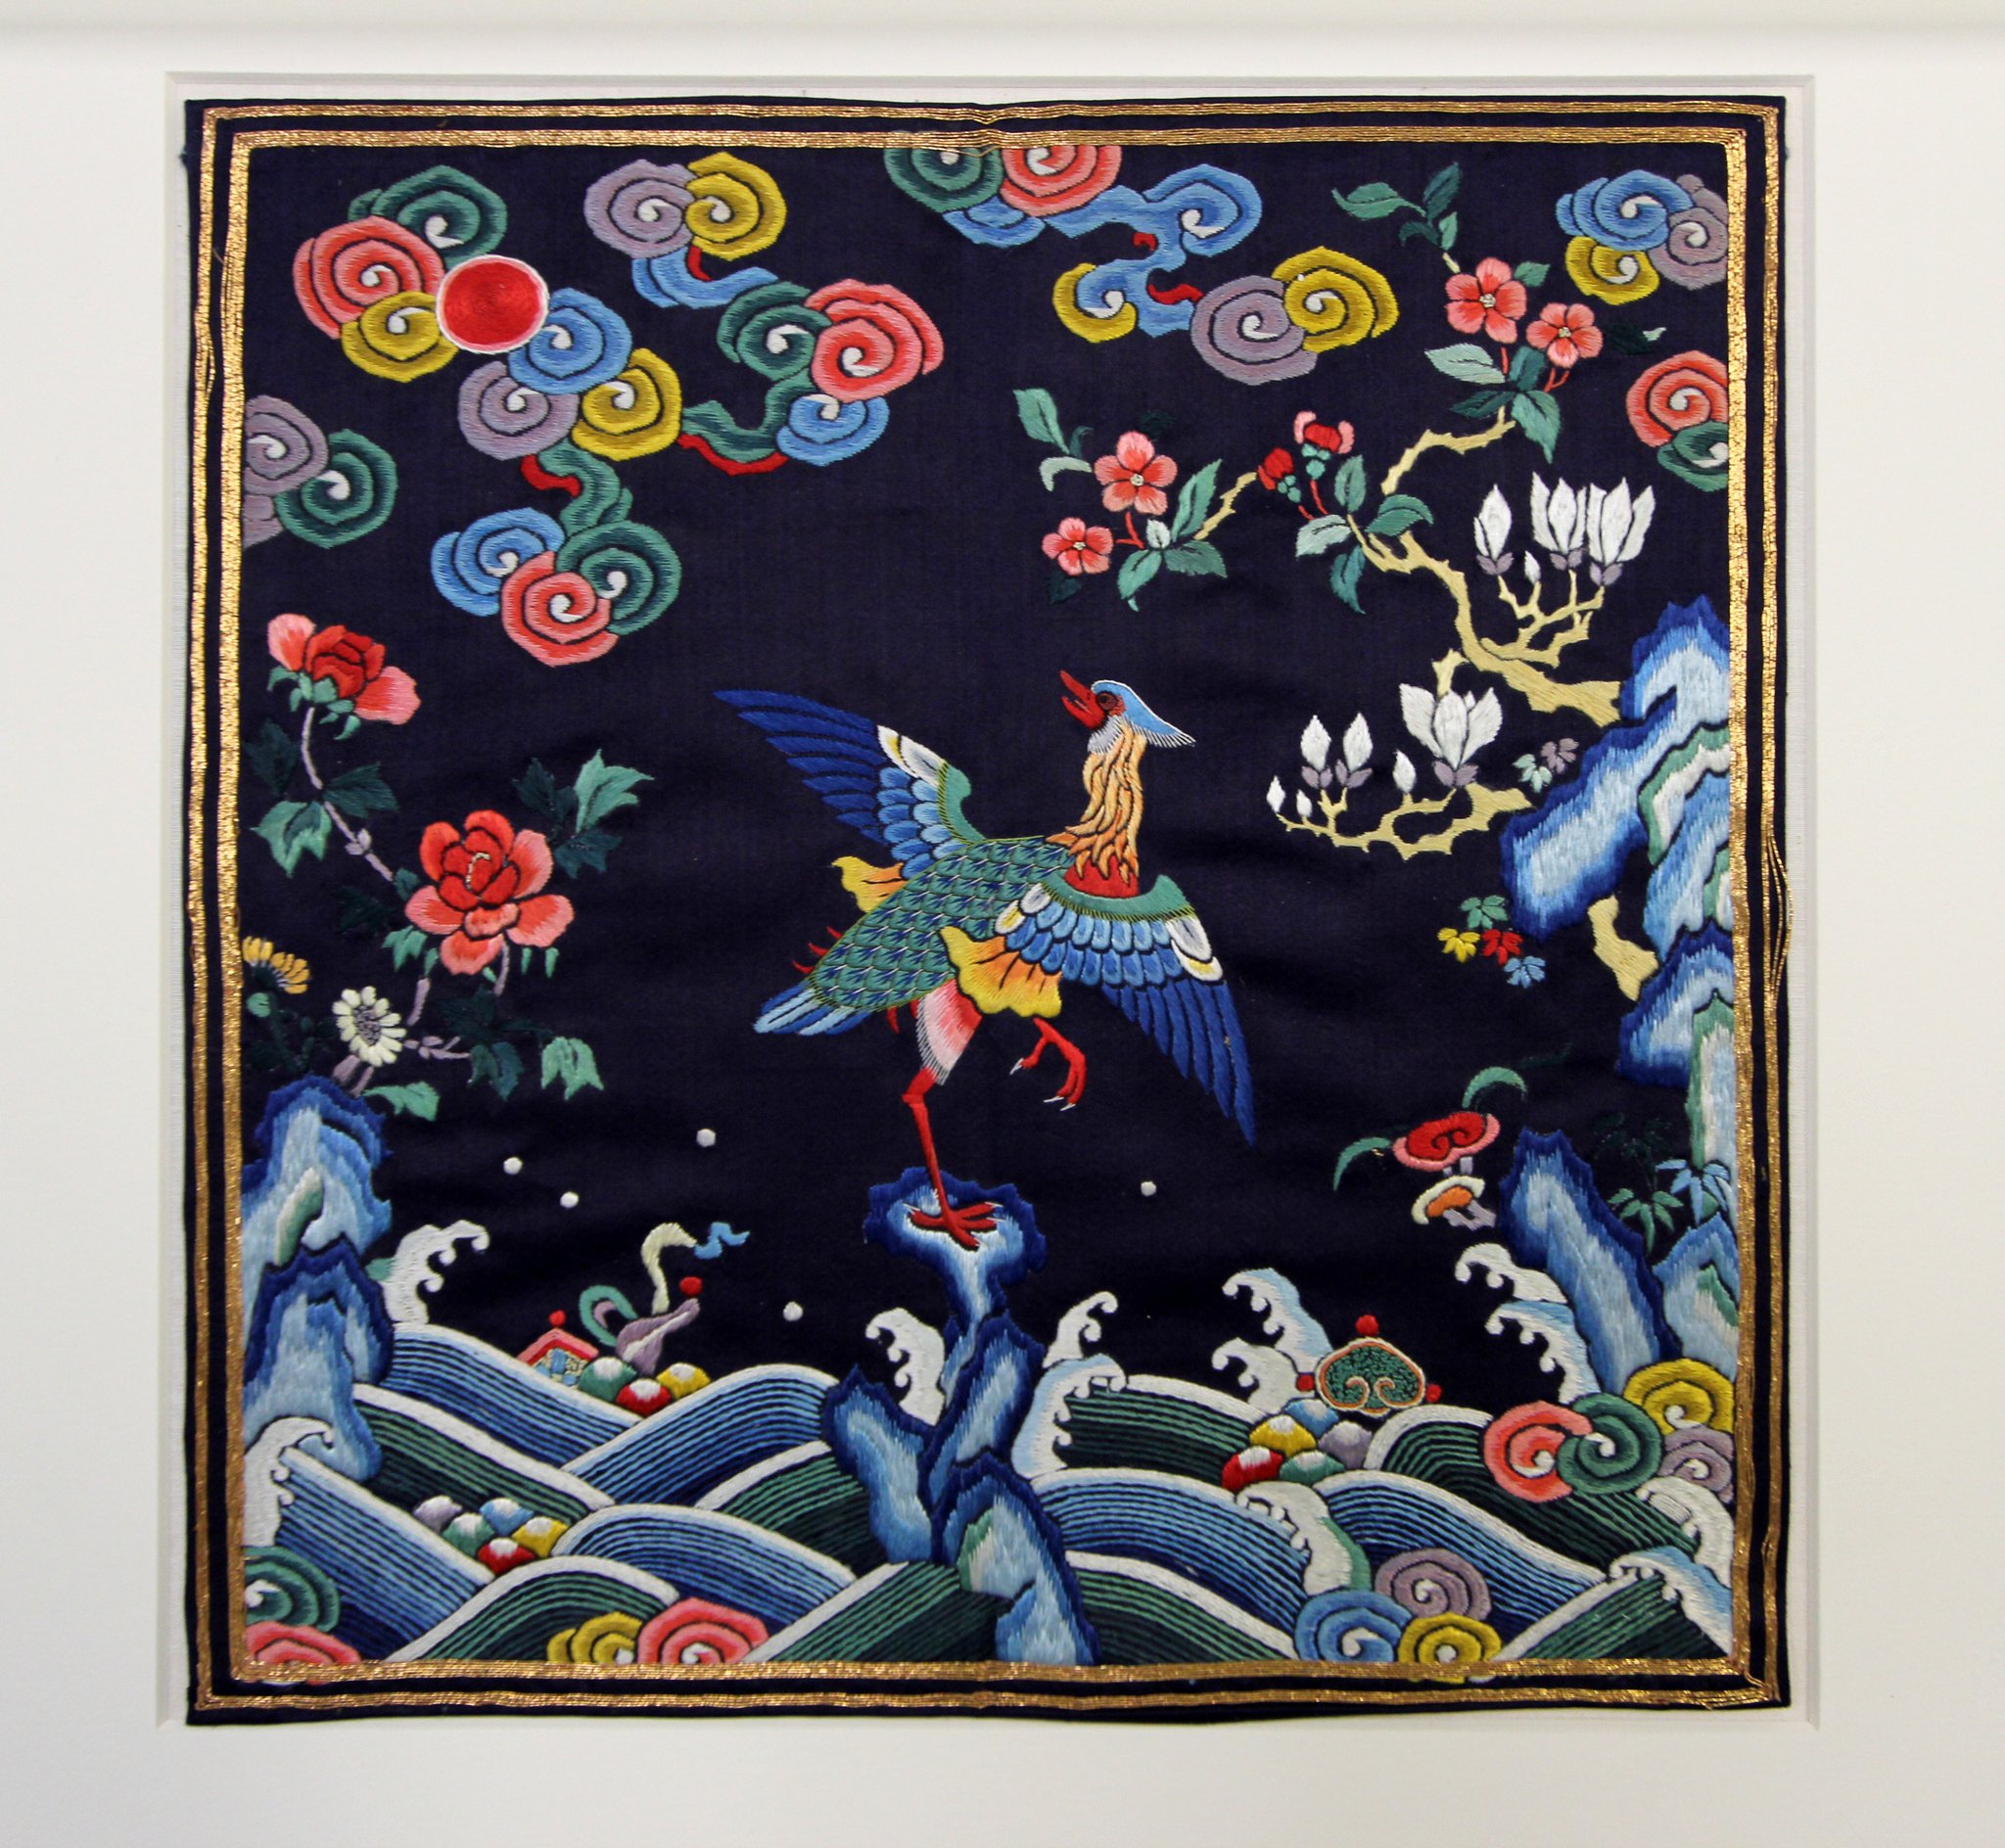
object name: rank badge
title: Rank Badge with Mandarin Duck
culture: chinese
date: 1701-1733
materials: metal thread, silk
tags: ducks